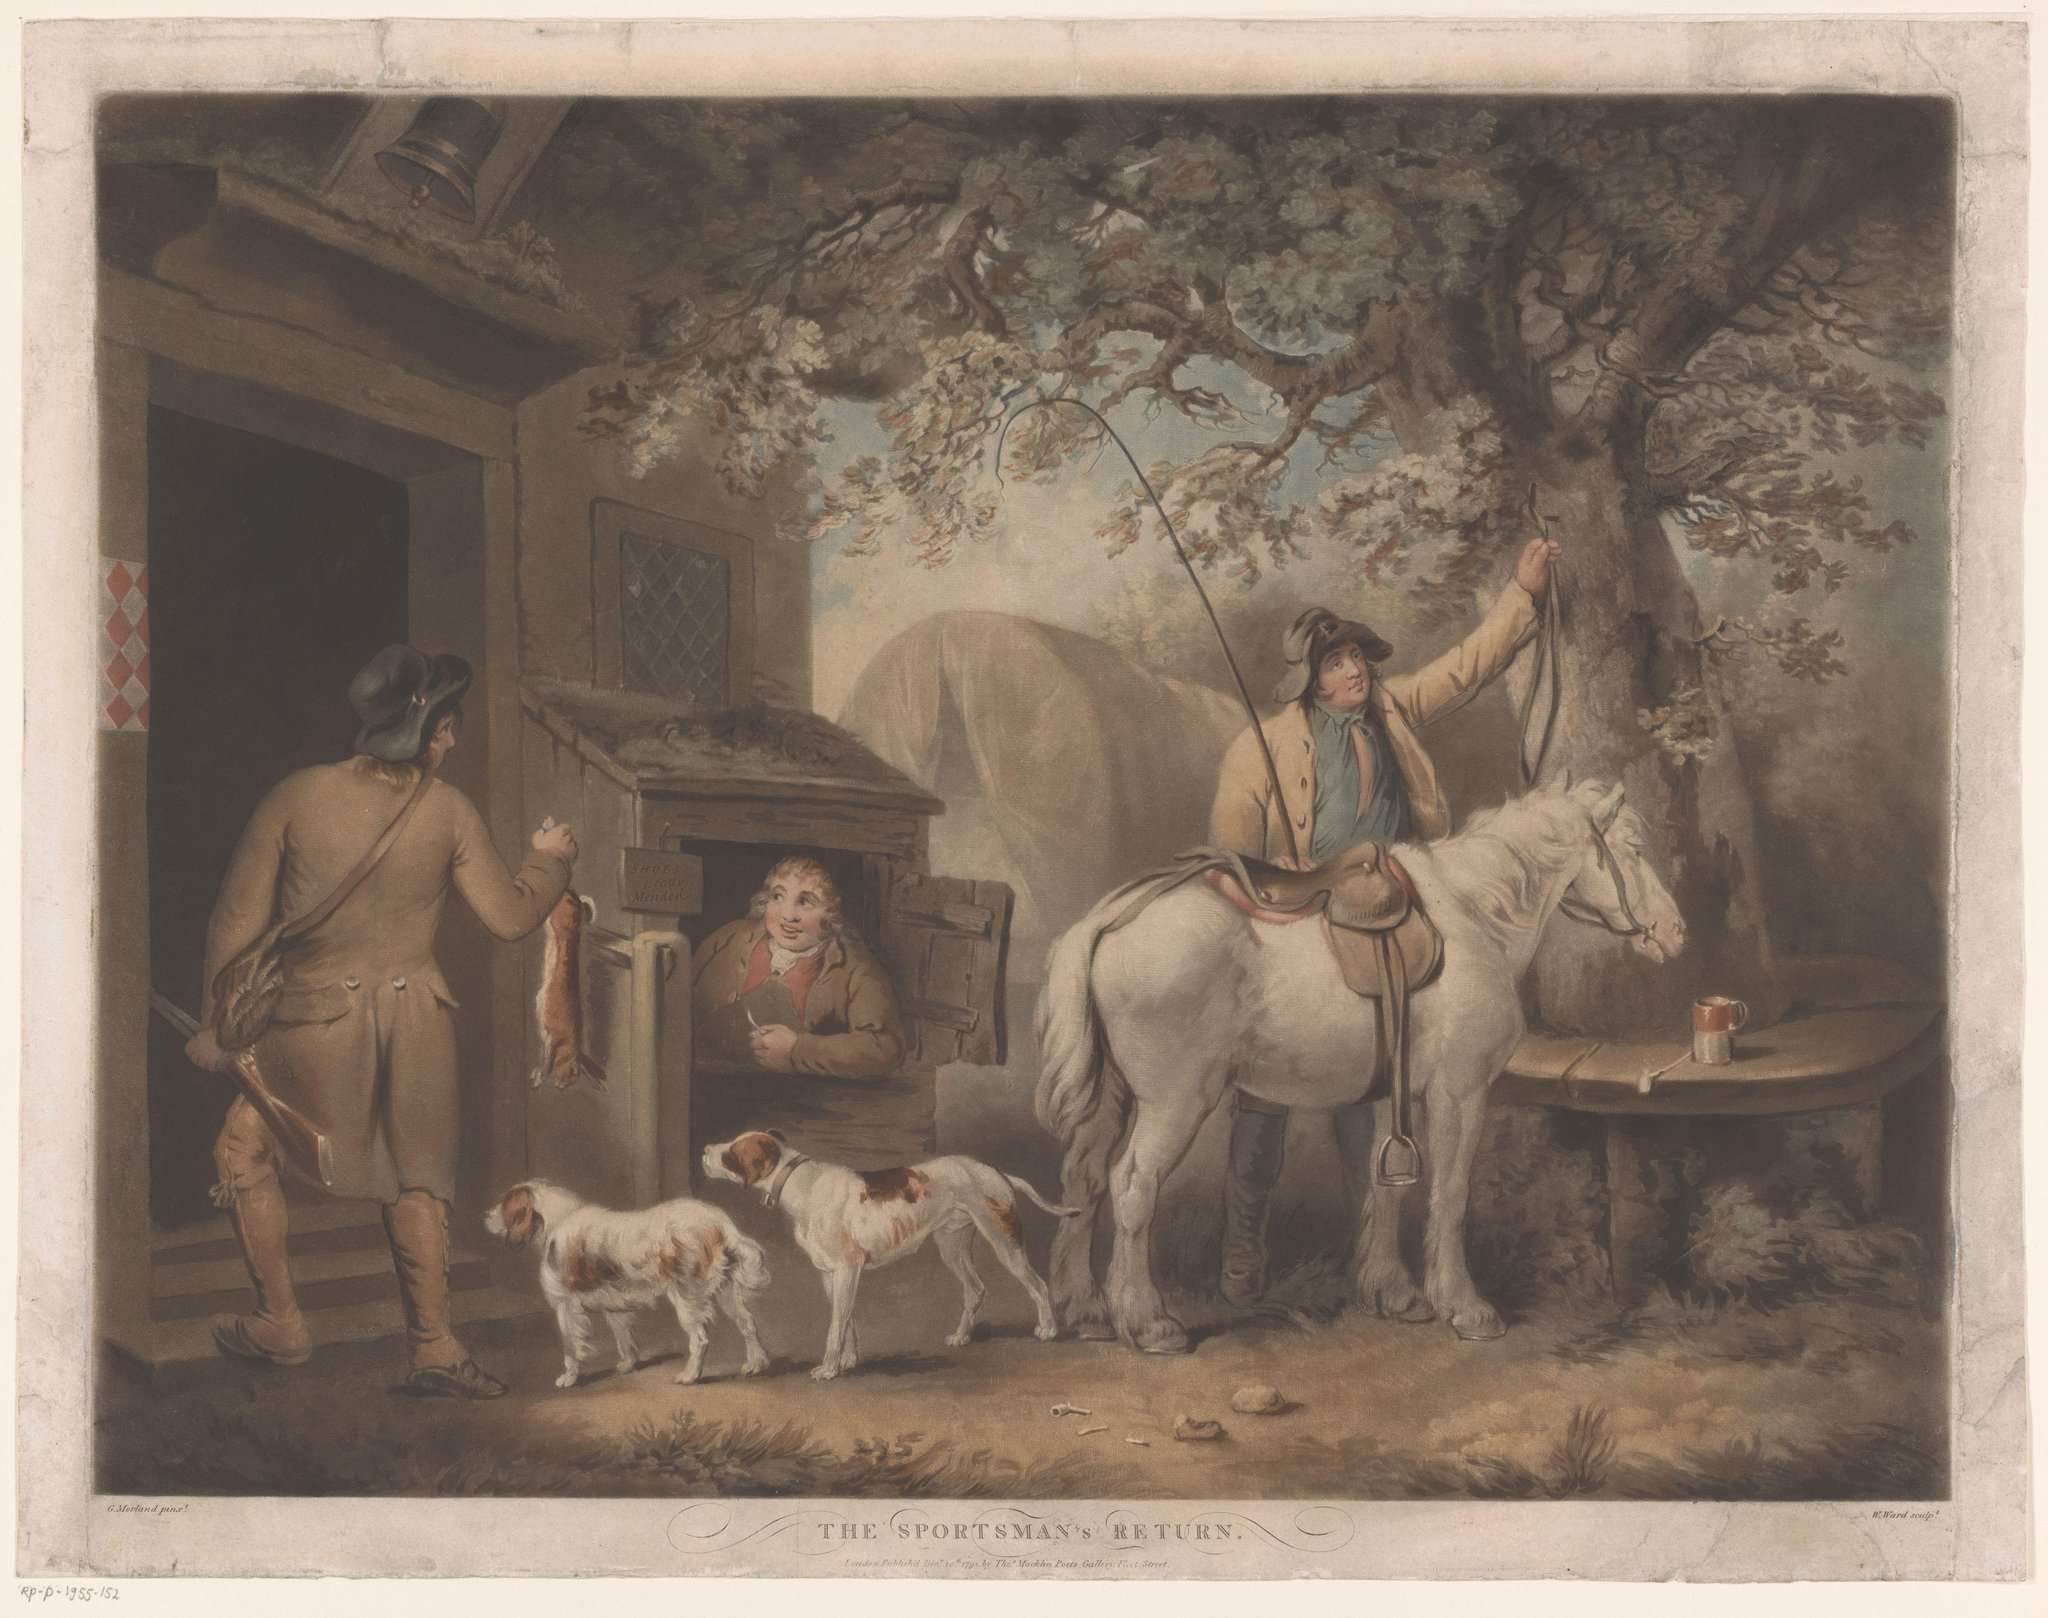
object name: print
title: Mannen en schoenmaker voor een herberg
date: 1792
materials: paper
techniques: engraving, hand coloring, lithography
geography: london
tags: riding a horse, ass, or mule; rider, horseman, hunter, hotel, hostelry, inn, shoe-maker, cobbler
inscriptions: date